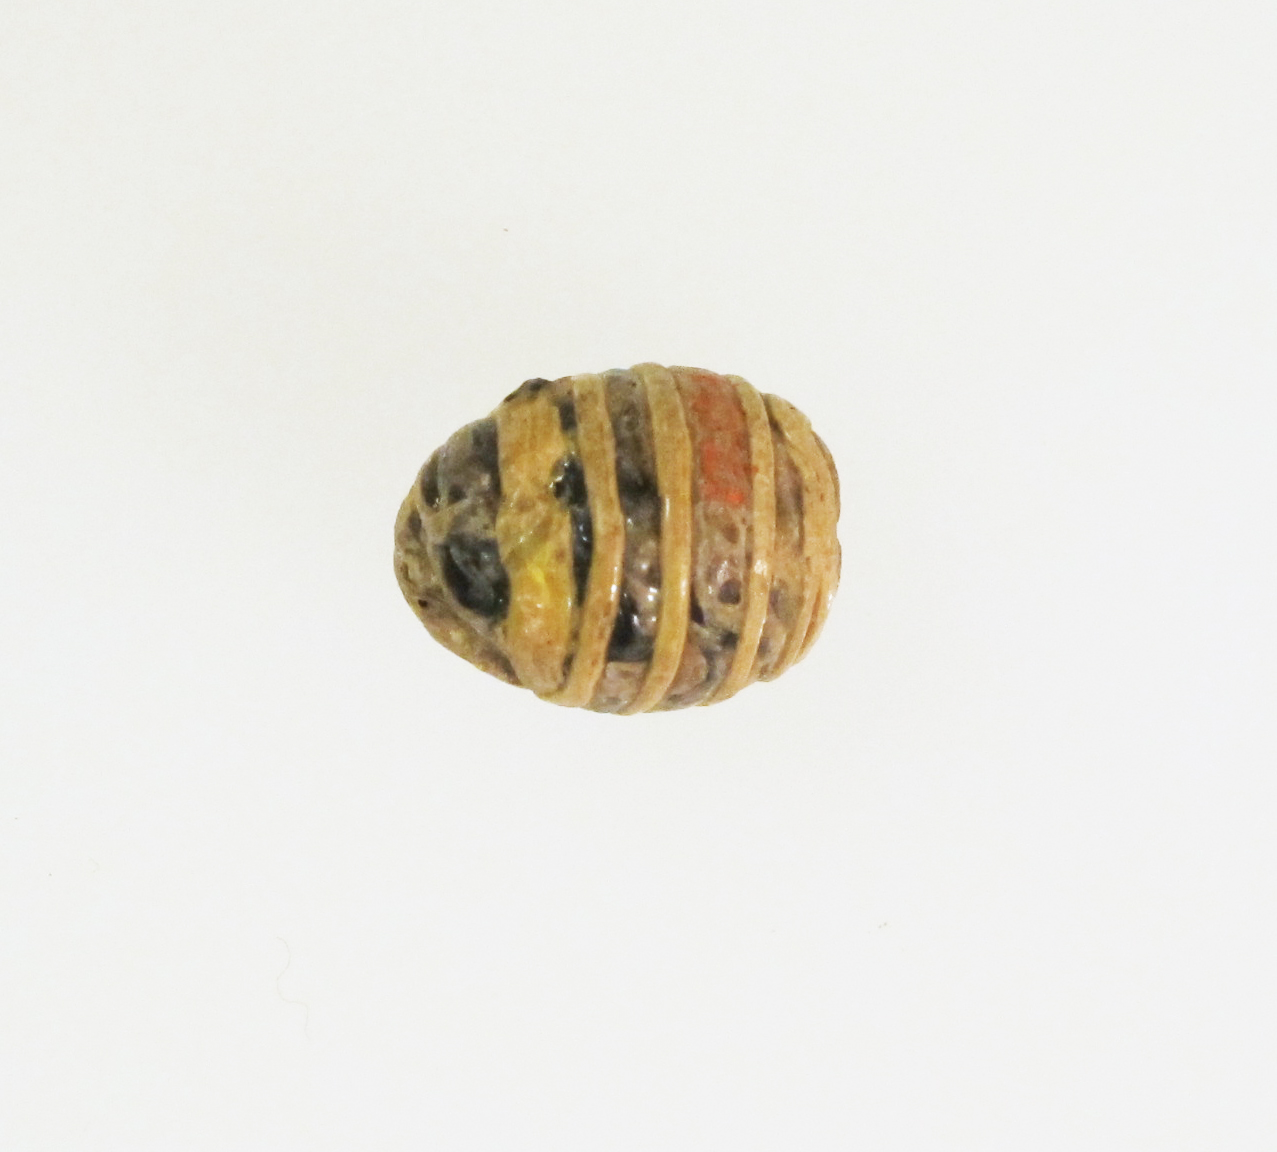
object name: bead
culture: roman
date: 670 BCE-330 CE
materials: glass